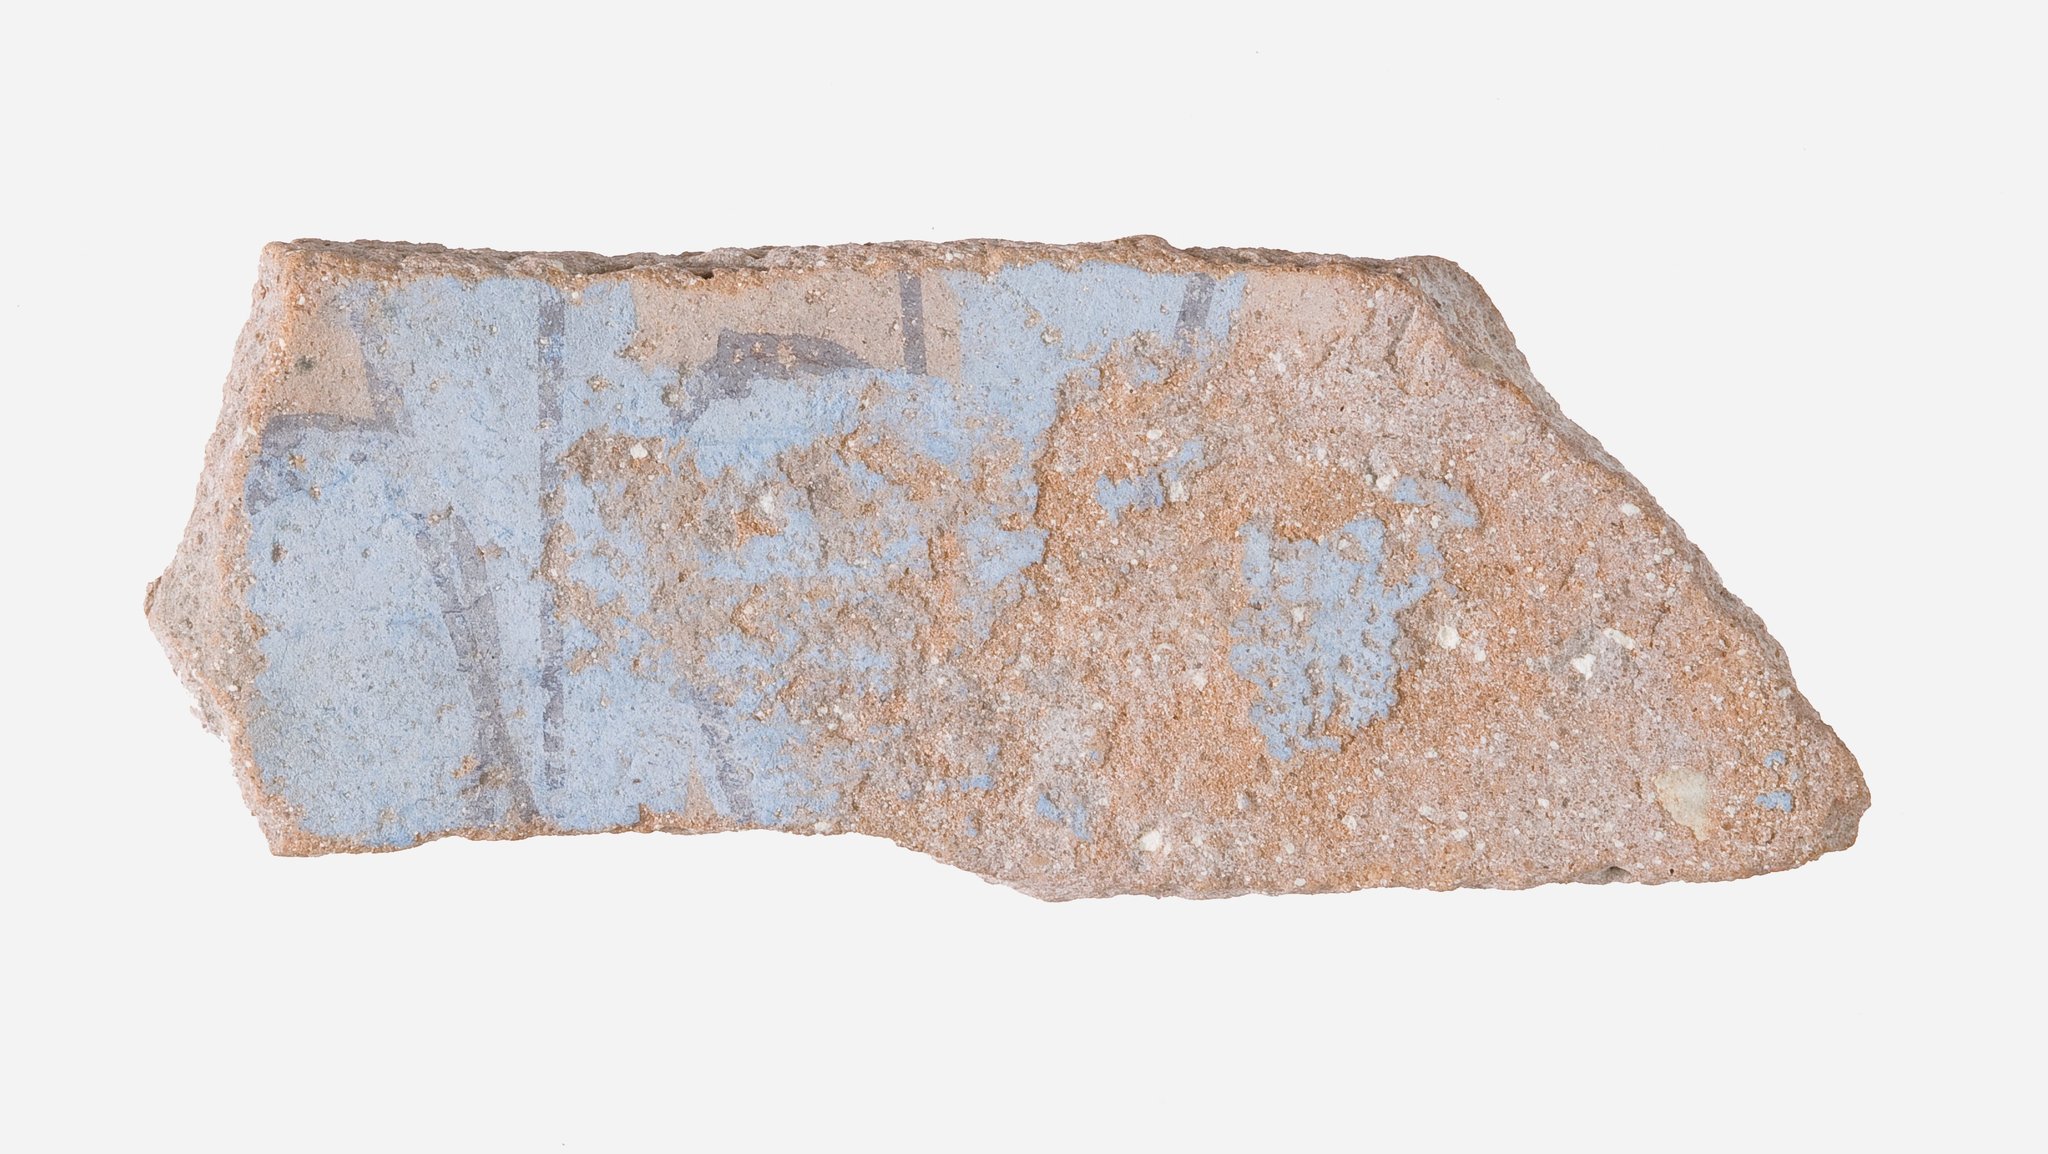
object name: vessel fragment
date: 1390-1352 BCE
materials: paint, pottery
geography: egypt